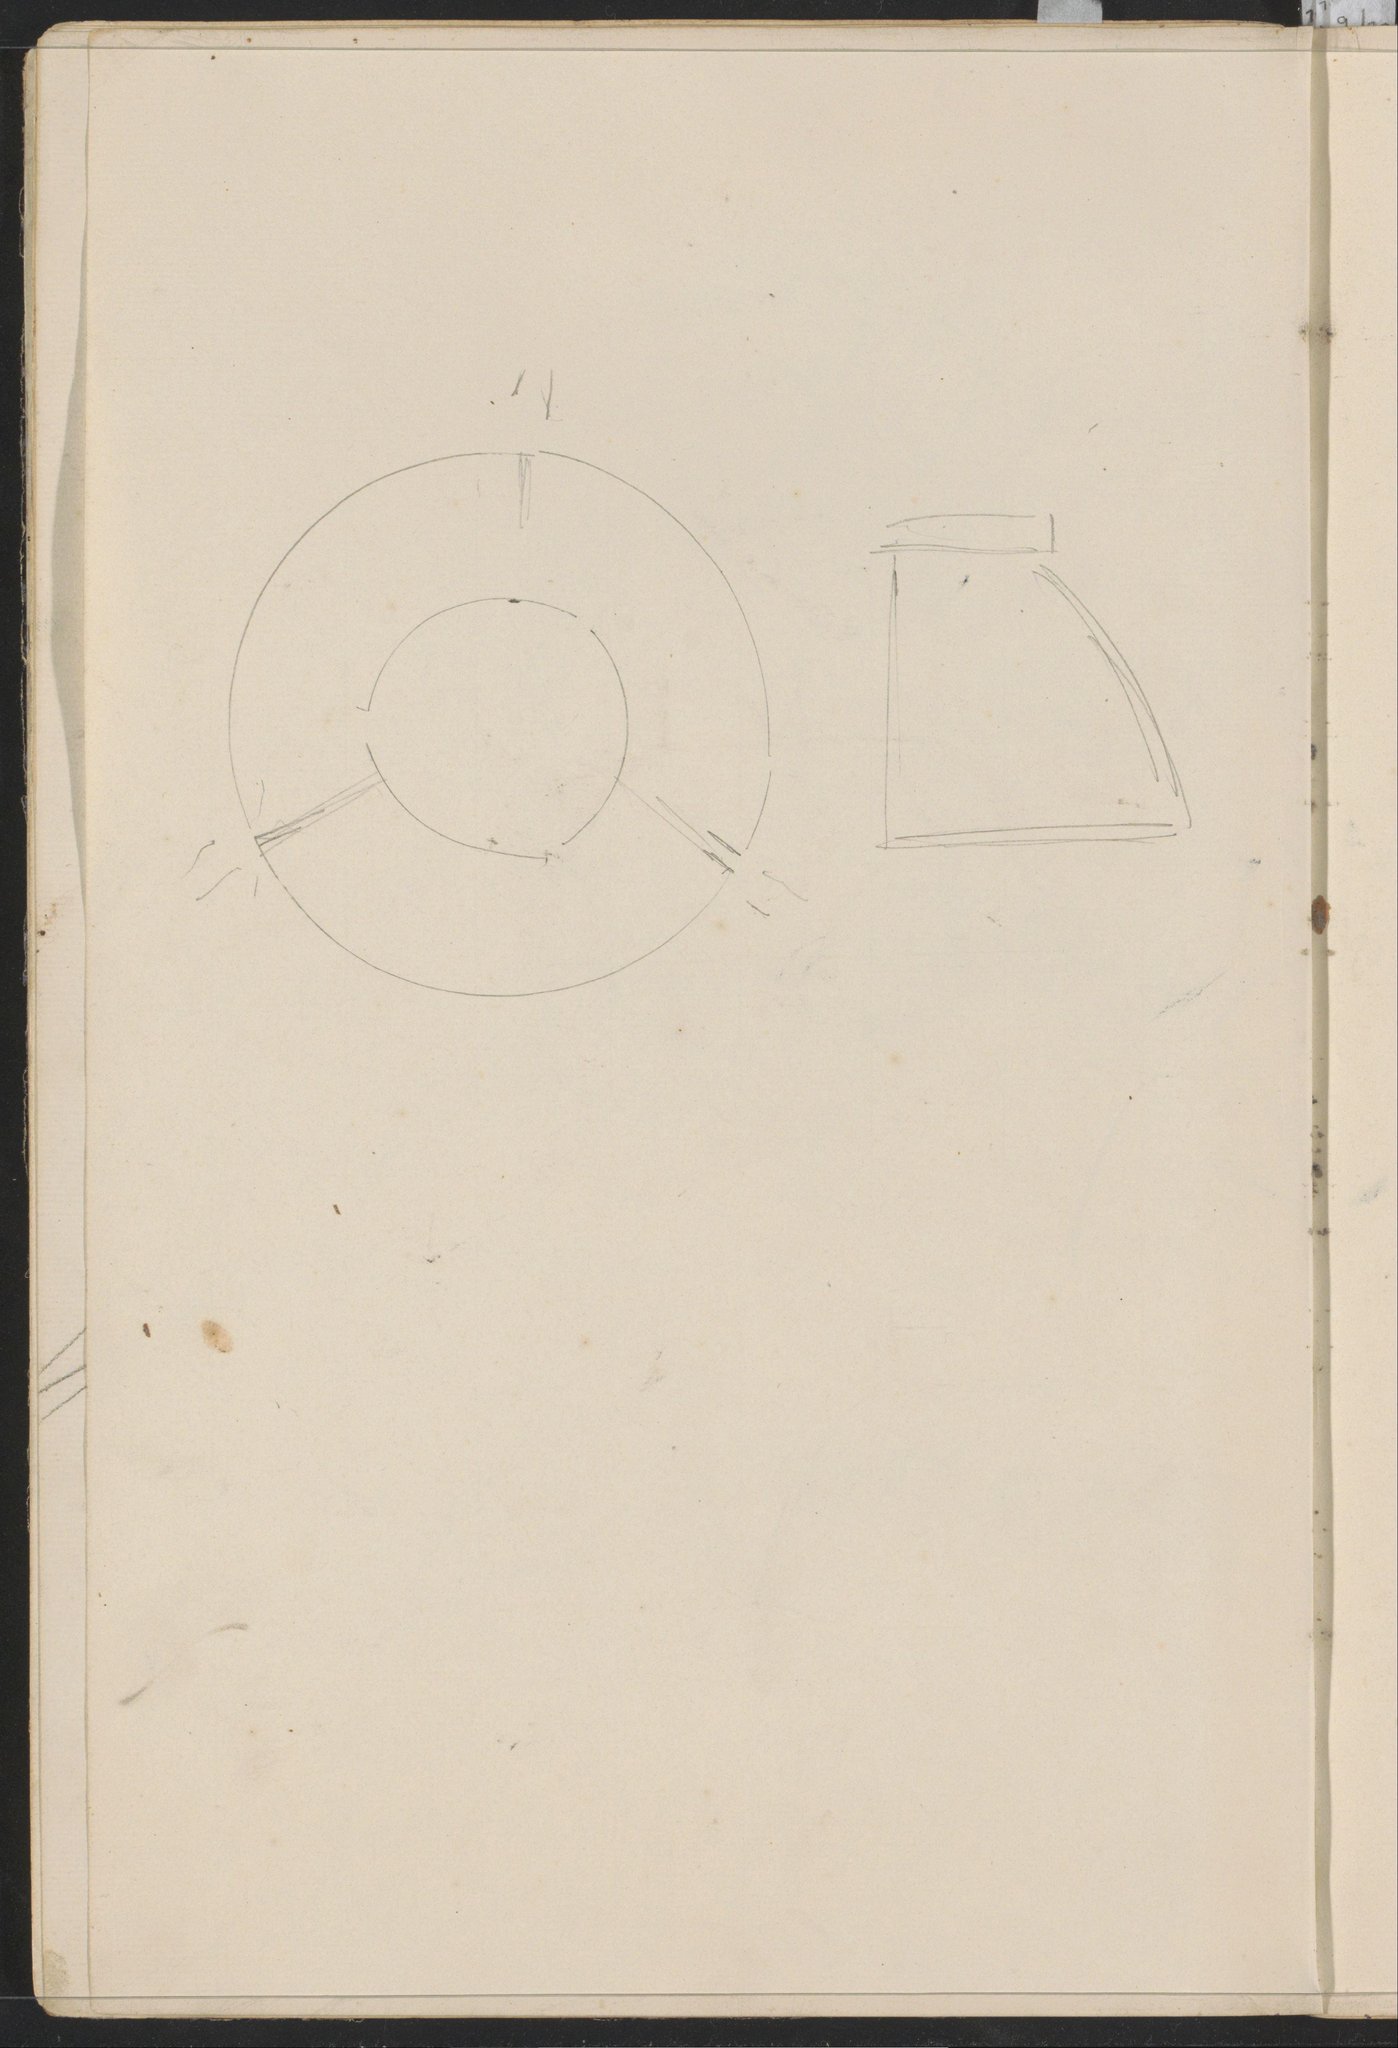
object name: sketchbook leaf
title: Cirkel in een cirkel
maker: carel adolph lion cachet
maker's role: draughtsman, print maker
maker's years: 1864-1945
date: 1897-1898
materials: paper, pencil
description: Tevens een studie. Blad 7 verso uit een schetsboek met 29 bladen.